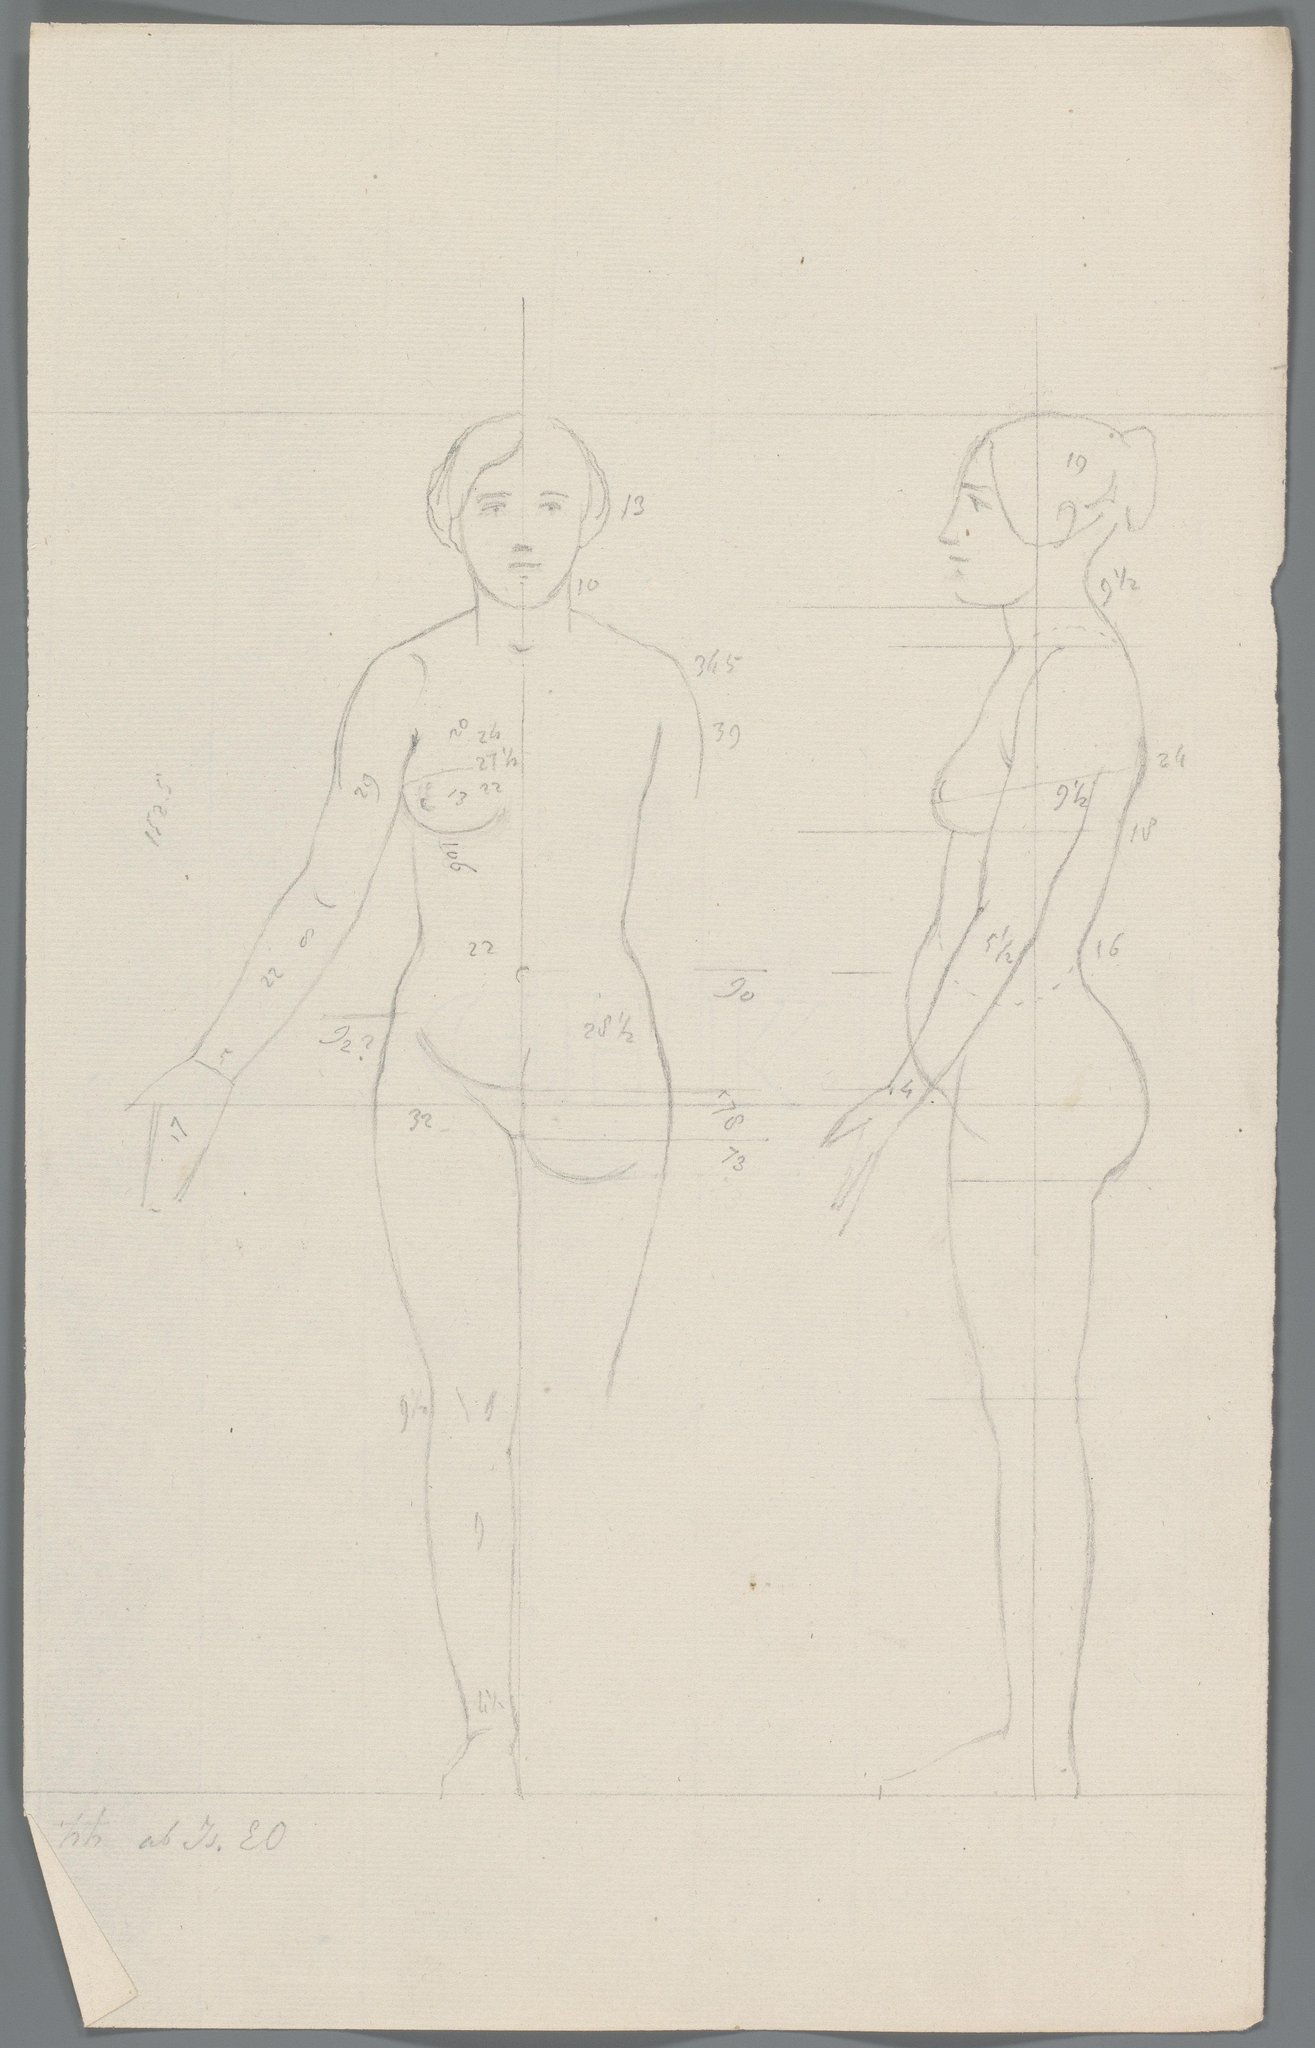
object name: drawing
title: Proportiestudie van een vrouw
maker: jacobus everhardus josephus van den berg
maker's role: draughtsman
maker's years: 1802-1861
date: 1854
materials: paper, pencil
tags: standing figure (canon, proportions) - aa - female human figure, anatomy (non-medical) - aa - female human figure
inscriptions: inscription: ‘hh ab Is ED’